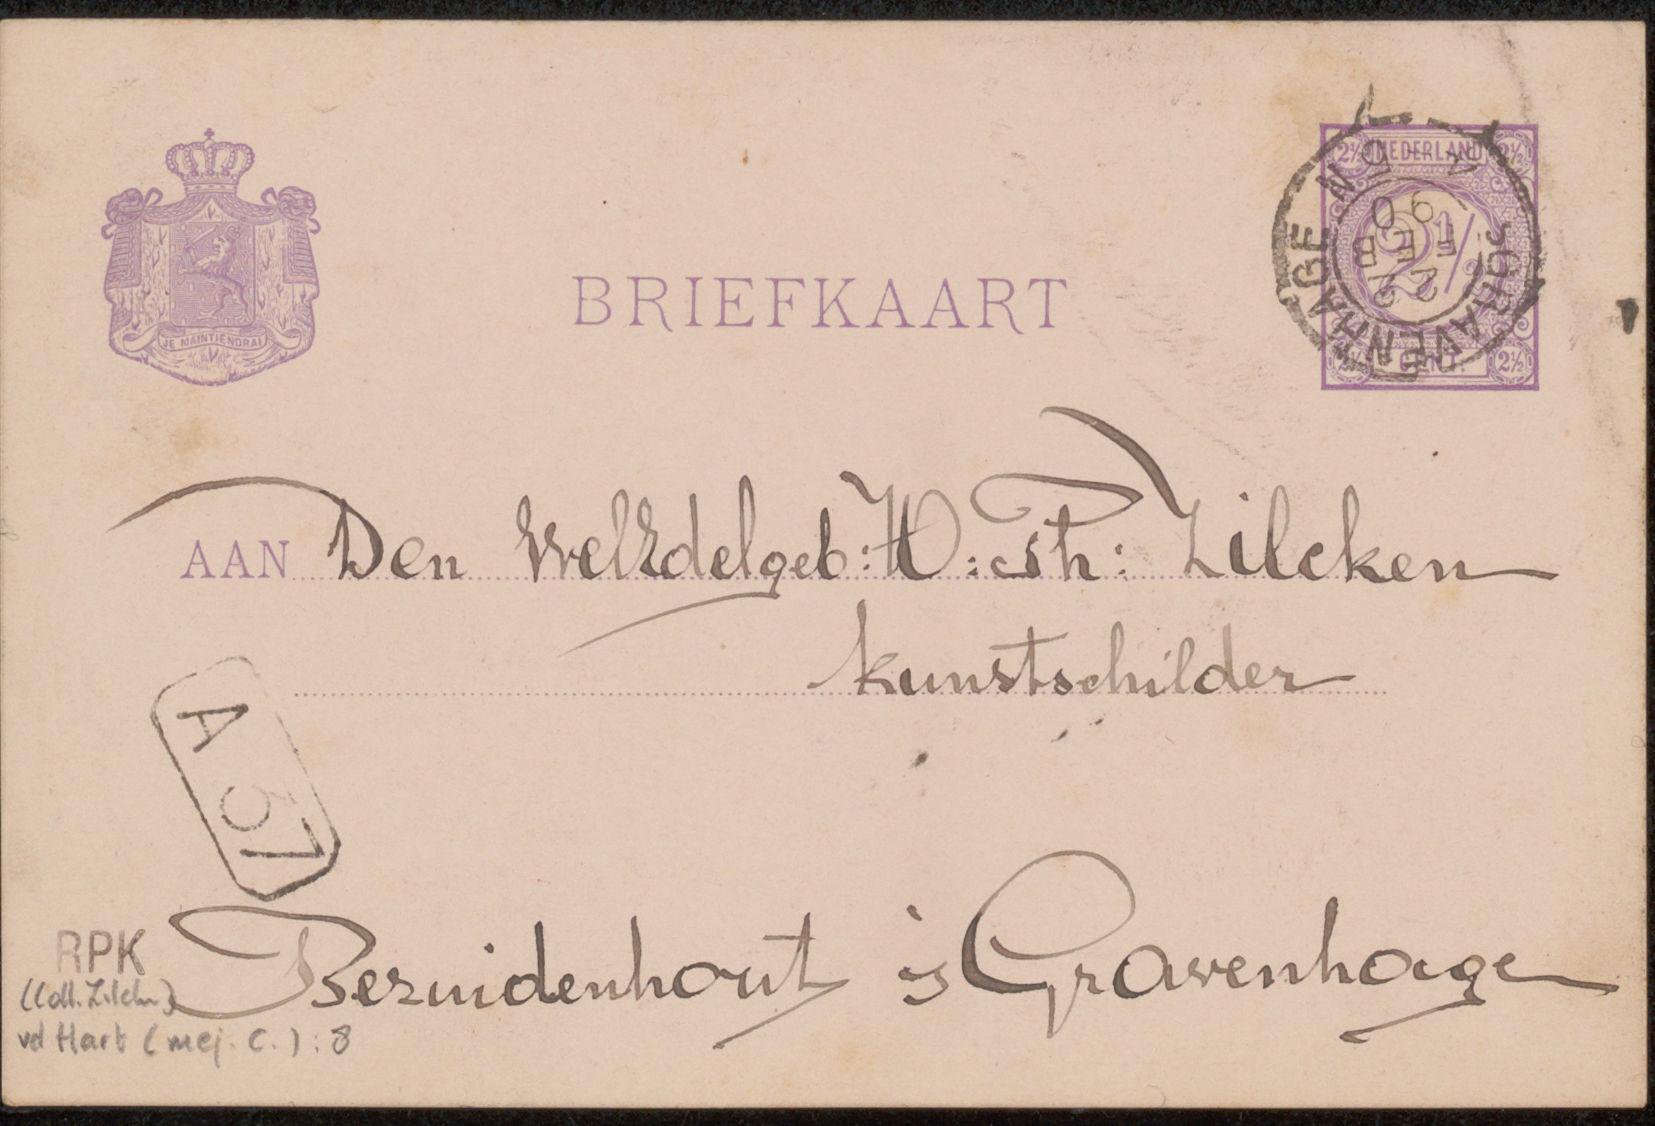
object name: postcard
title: Briefkaart aan Philip Zilcken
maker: cornelia van der hart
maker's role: print maker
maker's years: 1851-1940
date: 1890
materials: cardboard, ink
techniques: pen, writing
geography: the hague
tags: suze robertson, the hague, painter, draughtsman, philip zilcken, drawing, education, tuition of the artist (in general)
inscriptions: collector's mark: ‘RPK’